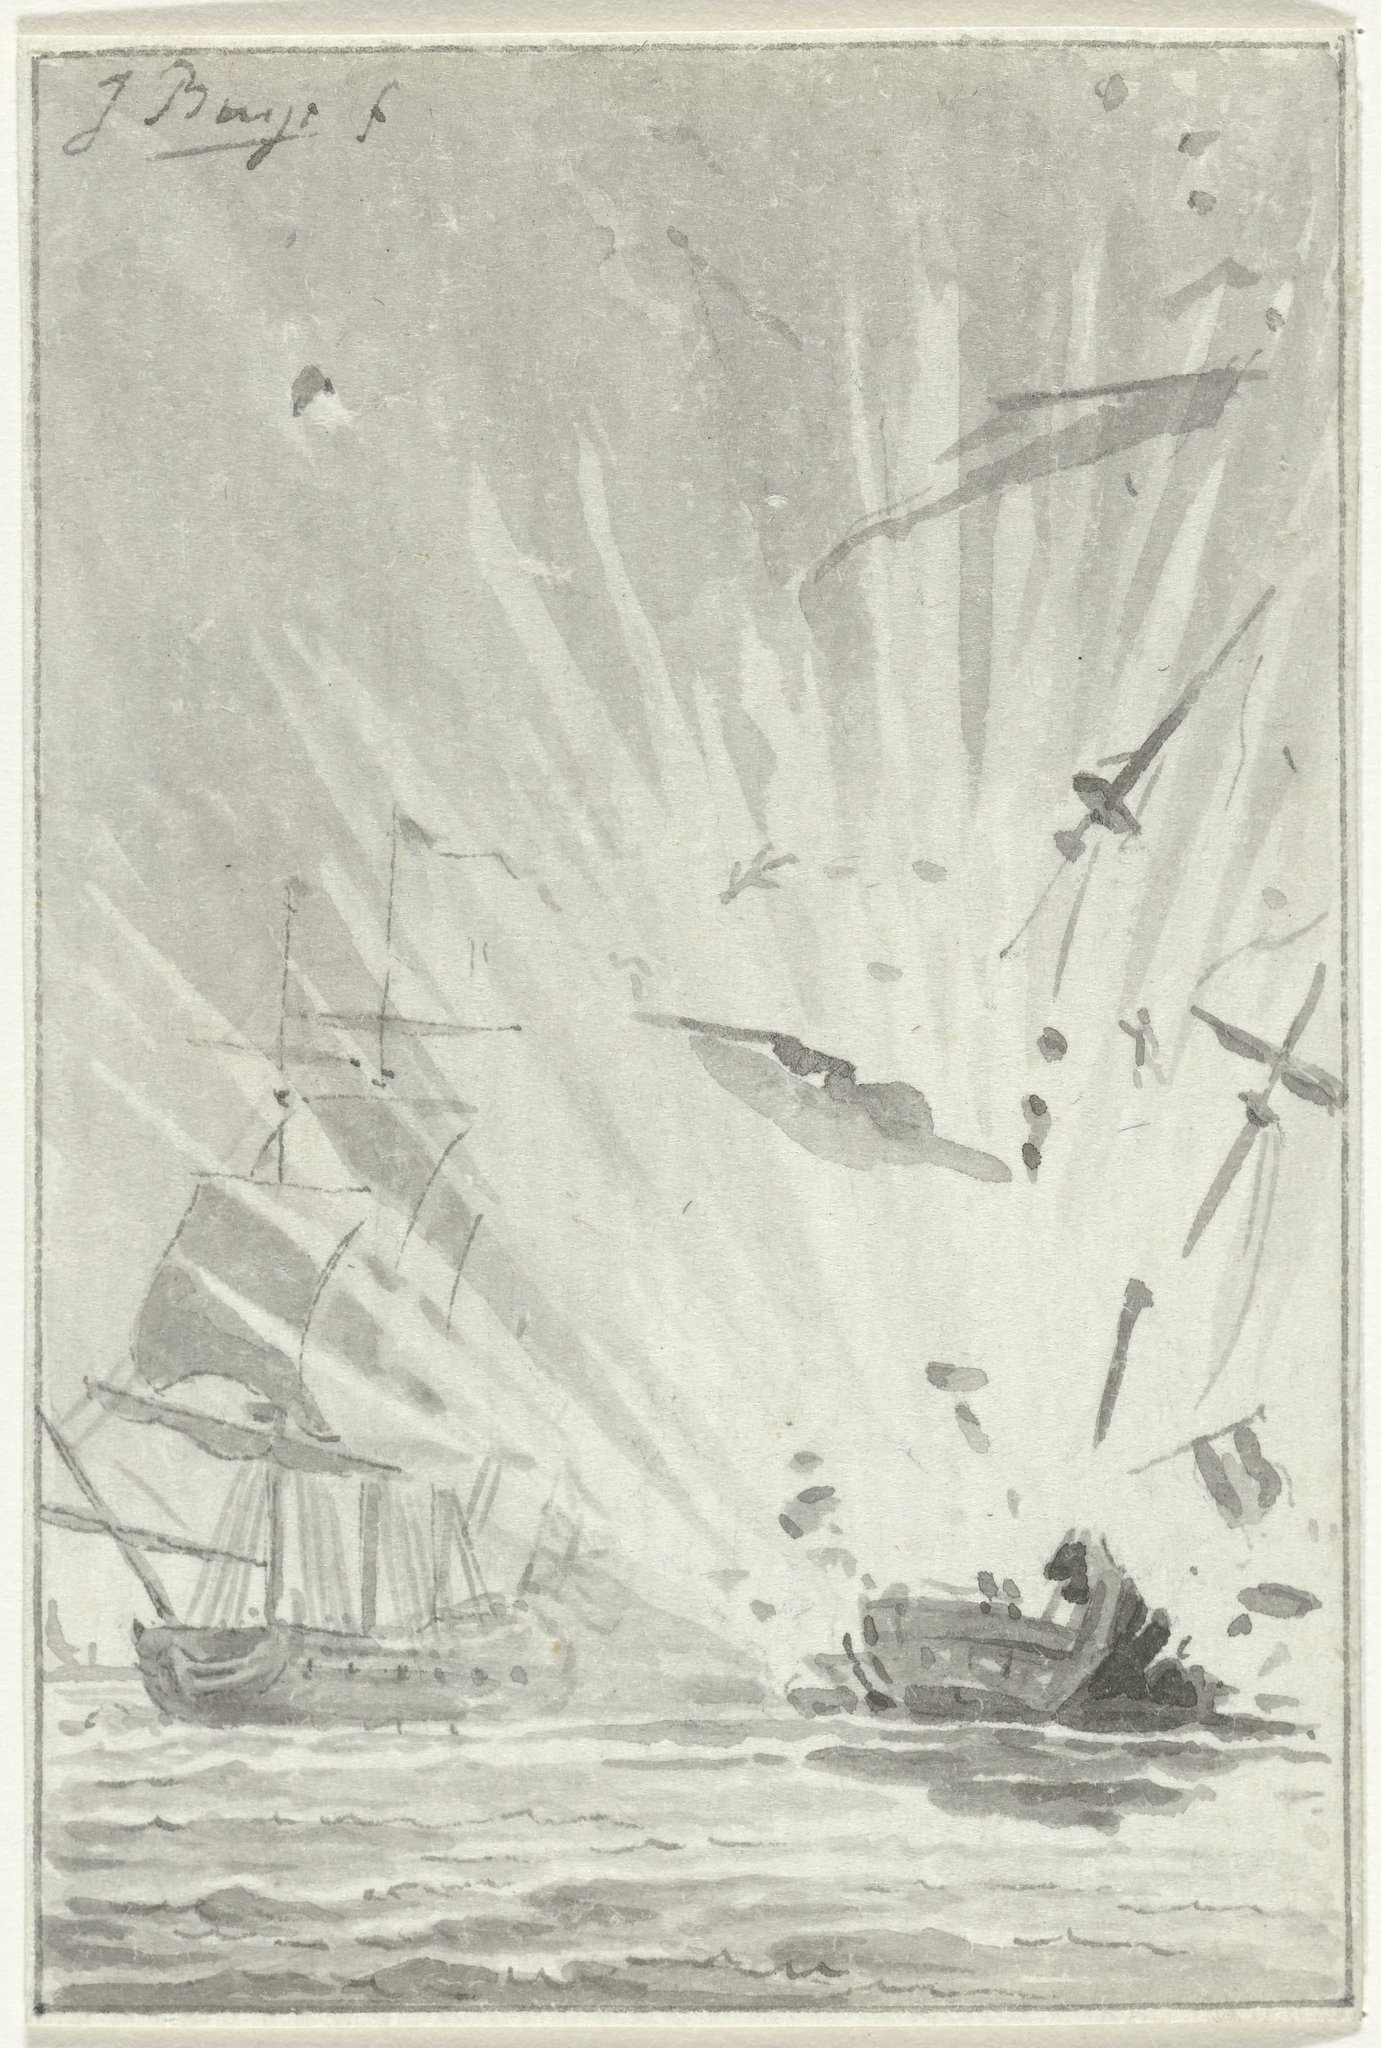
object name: drawing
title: Ontploffing van het Nederlandse kaperschip De Dappere Patriot in gevecht met het Engelse schip Kameleon, 14 augustus 1781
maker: jacobus buys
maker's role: draughtsman, print maker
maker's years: 1724-1801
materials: ink, paper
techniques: brush, pen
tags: names of artefacts and man-made objects (buildings excluded), battle (+ naval force), historical events and situations